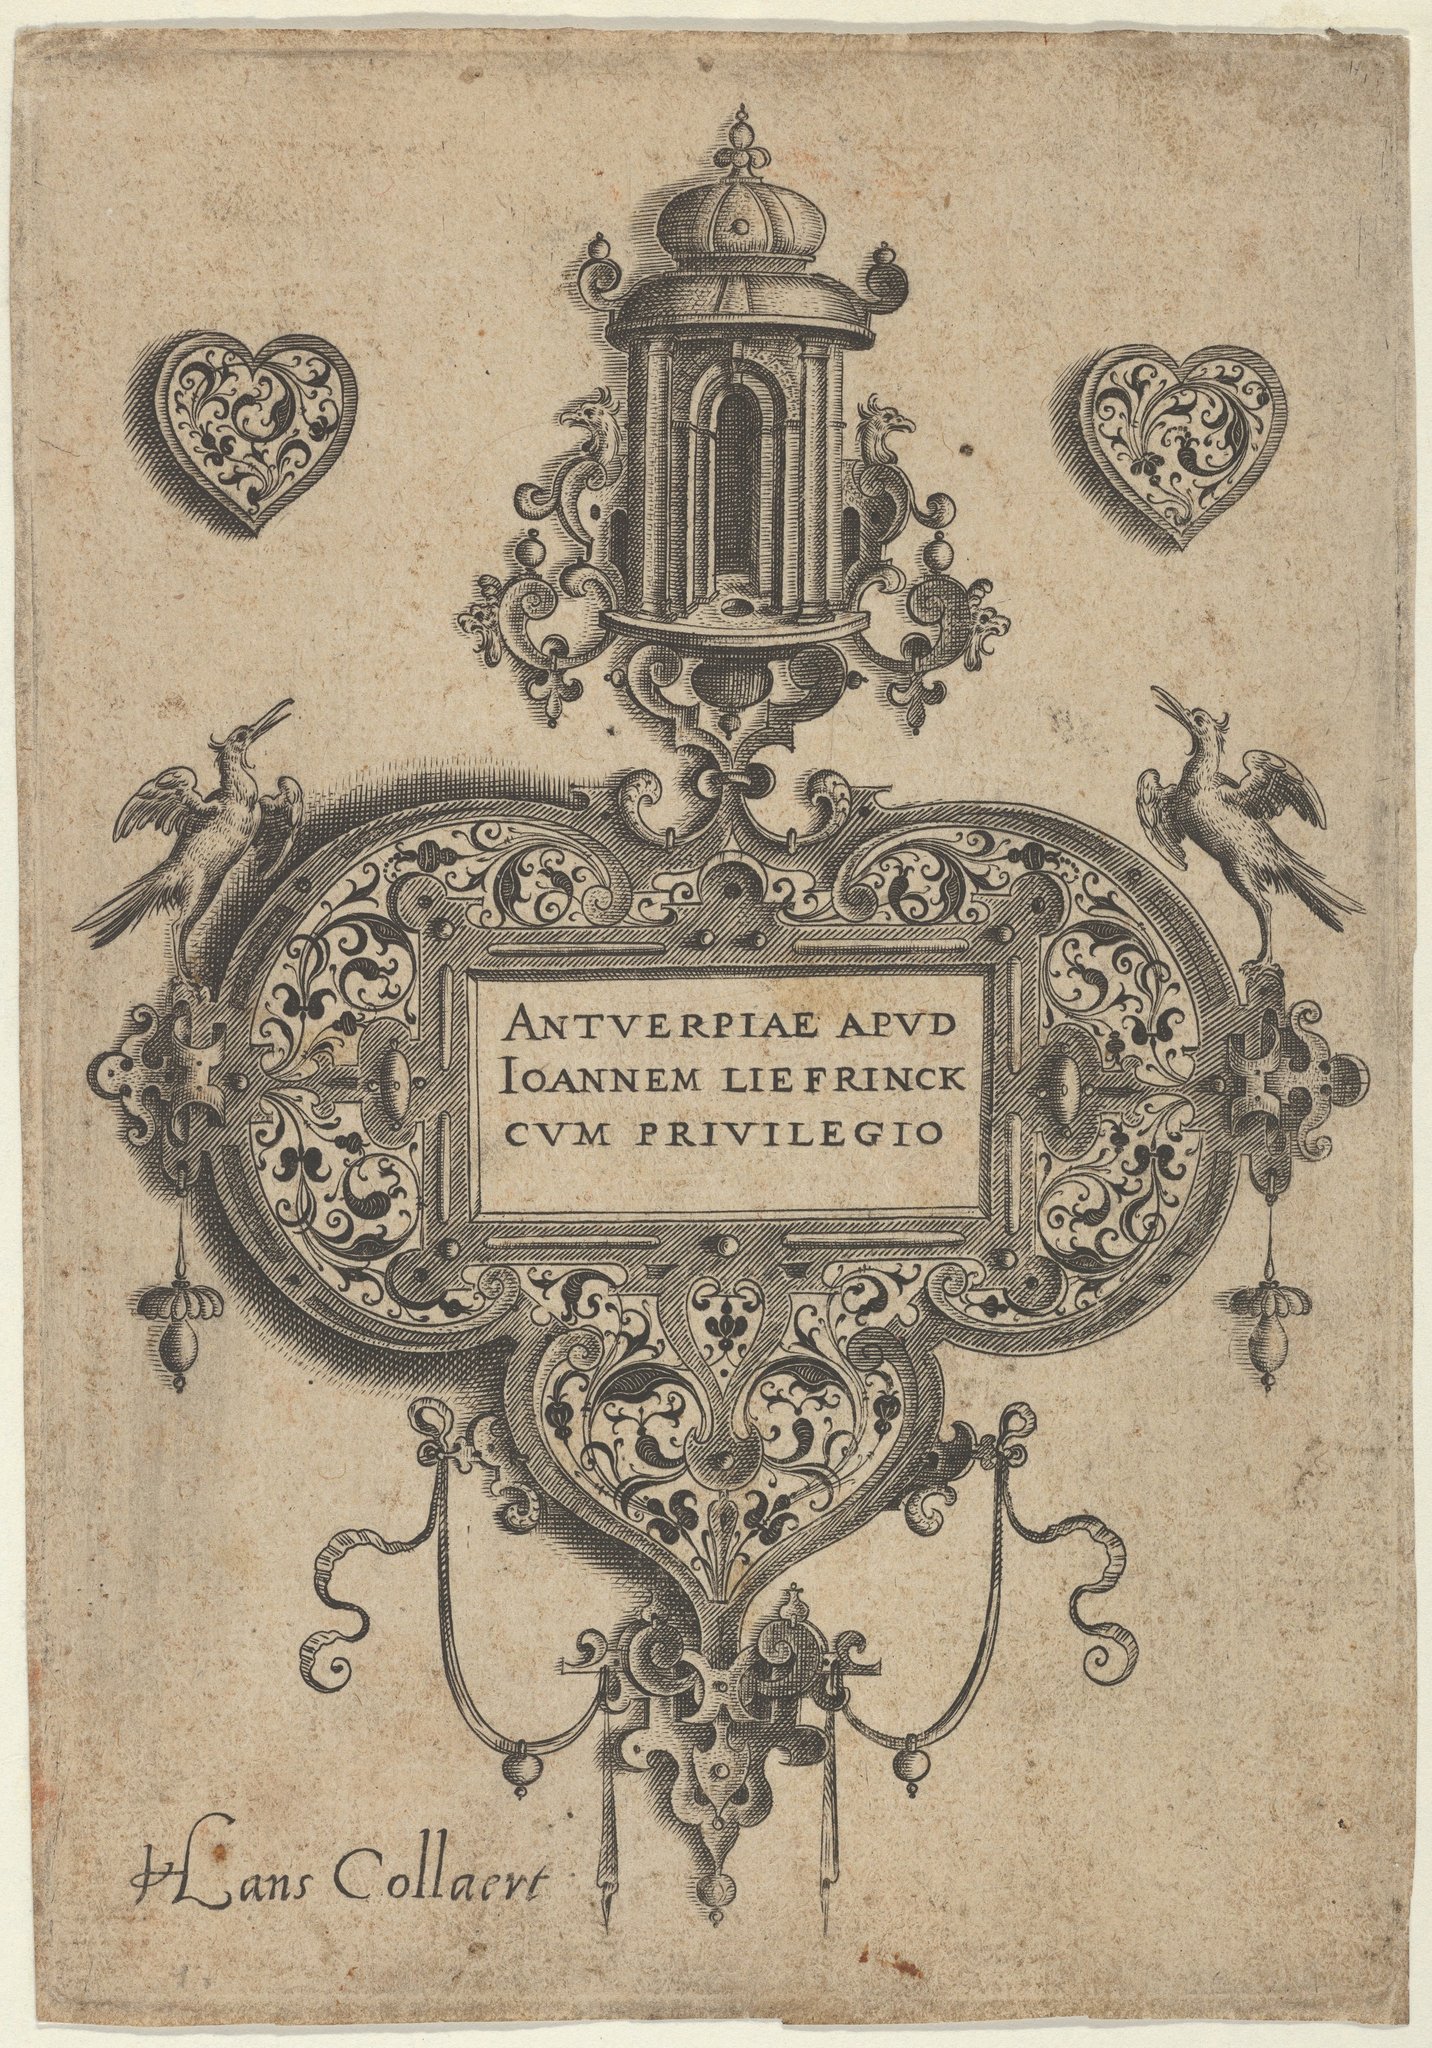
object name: print ornament architecture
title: Title Plate, from "Pendant Designs with Architectural Elements and Vegetal-Arabesques"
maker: jan collaert i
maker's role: artist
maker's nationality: netherlandish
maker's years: 1530-1581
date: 1573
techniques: embroidery, engraving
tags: birds,cartouches,ornament